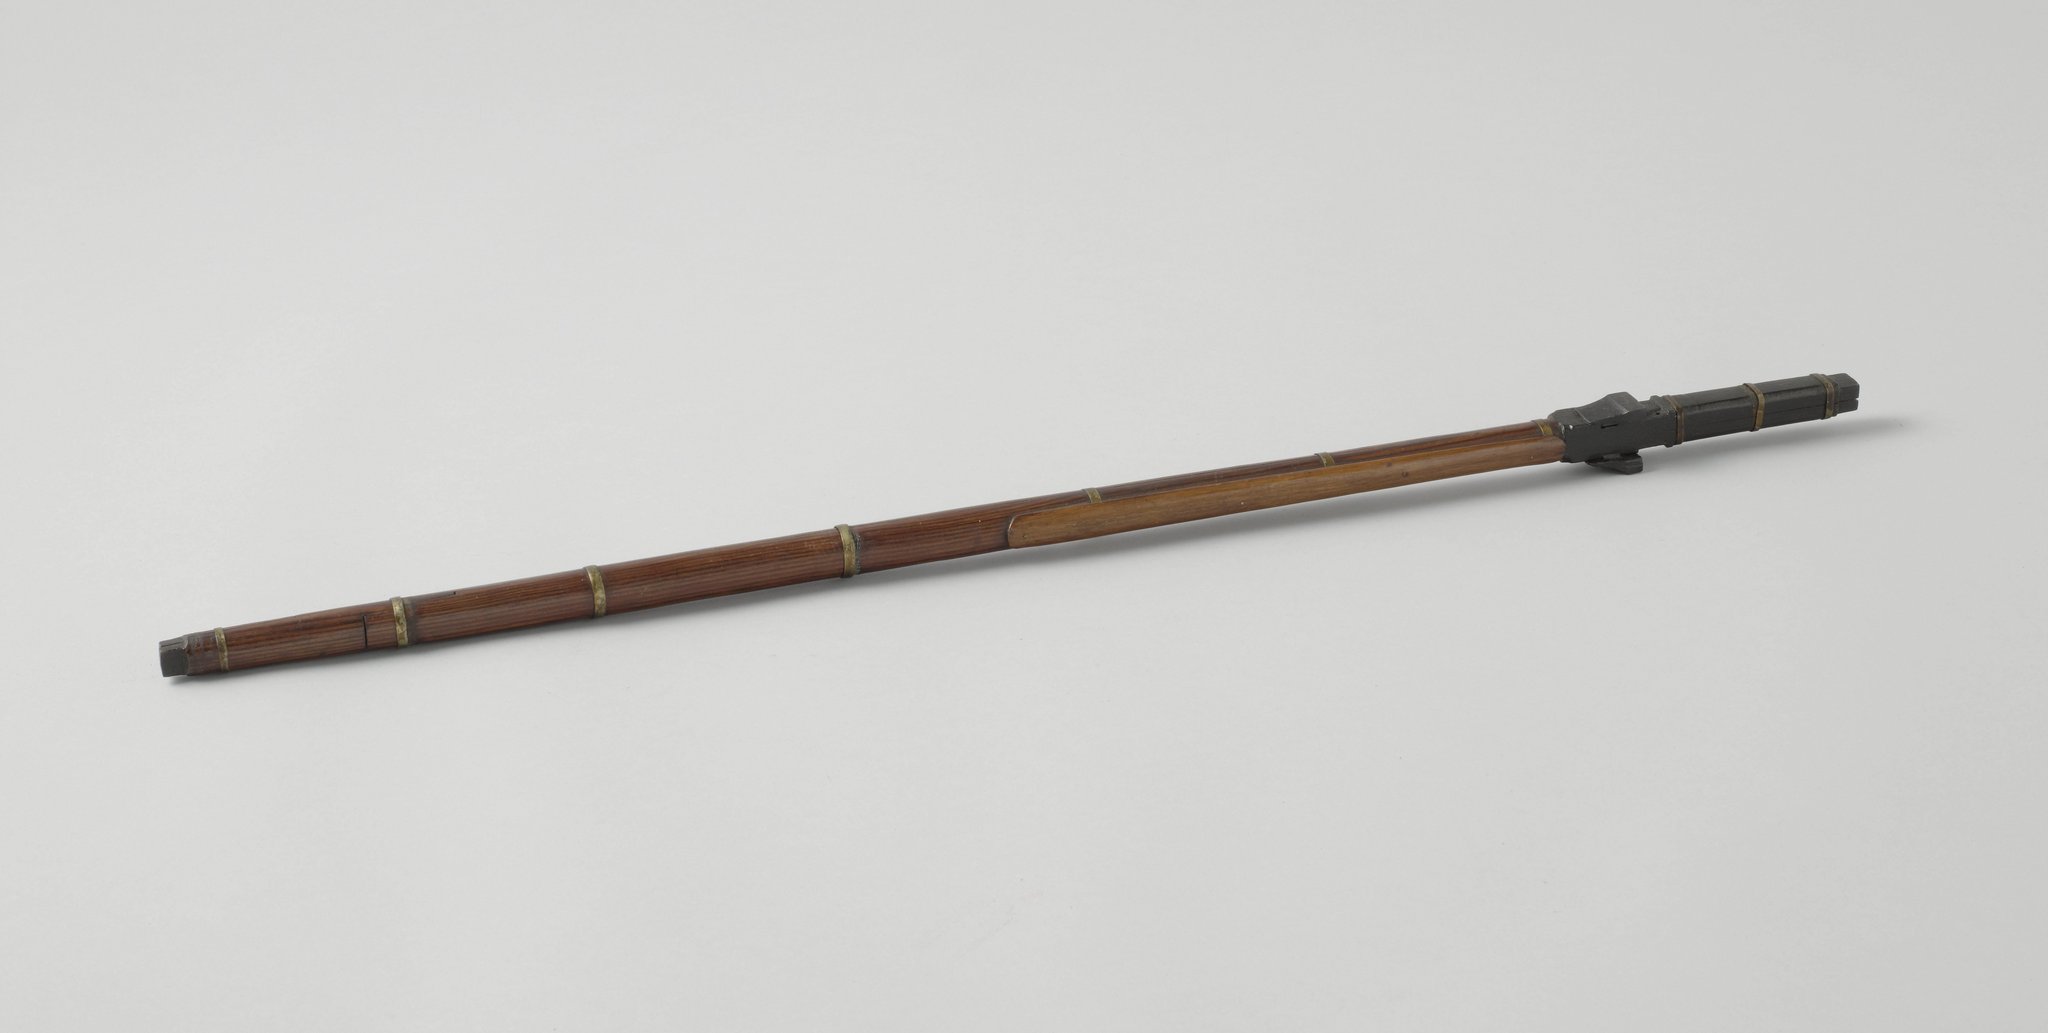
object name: demonstration model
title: Model of a Made Mast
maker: Anonymous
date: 1780-1840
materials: brass, wood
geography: netherlands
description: Ronde mast met vierkante top, hommer met oren en rijschaal. De mastvoet bestaat uit drie delen, een kort stuk voor en twee lange achter, die geheel naar de top doorlopen. Met een schuine las wordt het korte stuk verlengd tot op de hoogte van de mars; de masttop is weer uit vier delen samengesteld. Alle delen zijn binnenin met lassen aan elkaar verbonden en worden door kuipbanden bijeengehouden. De oren zijn vrij kort en de mast is voorzien van een rijschaal.